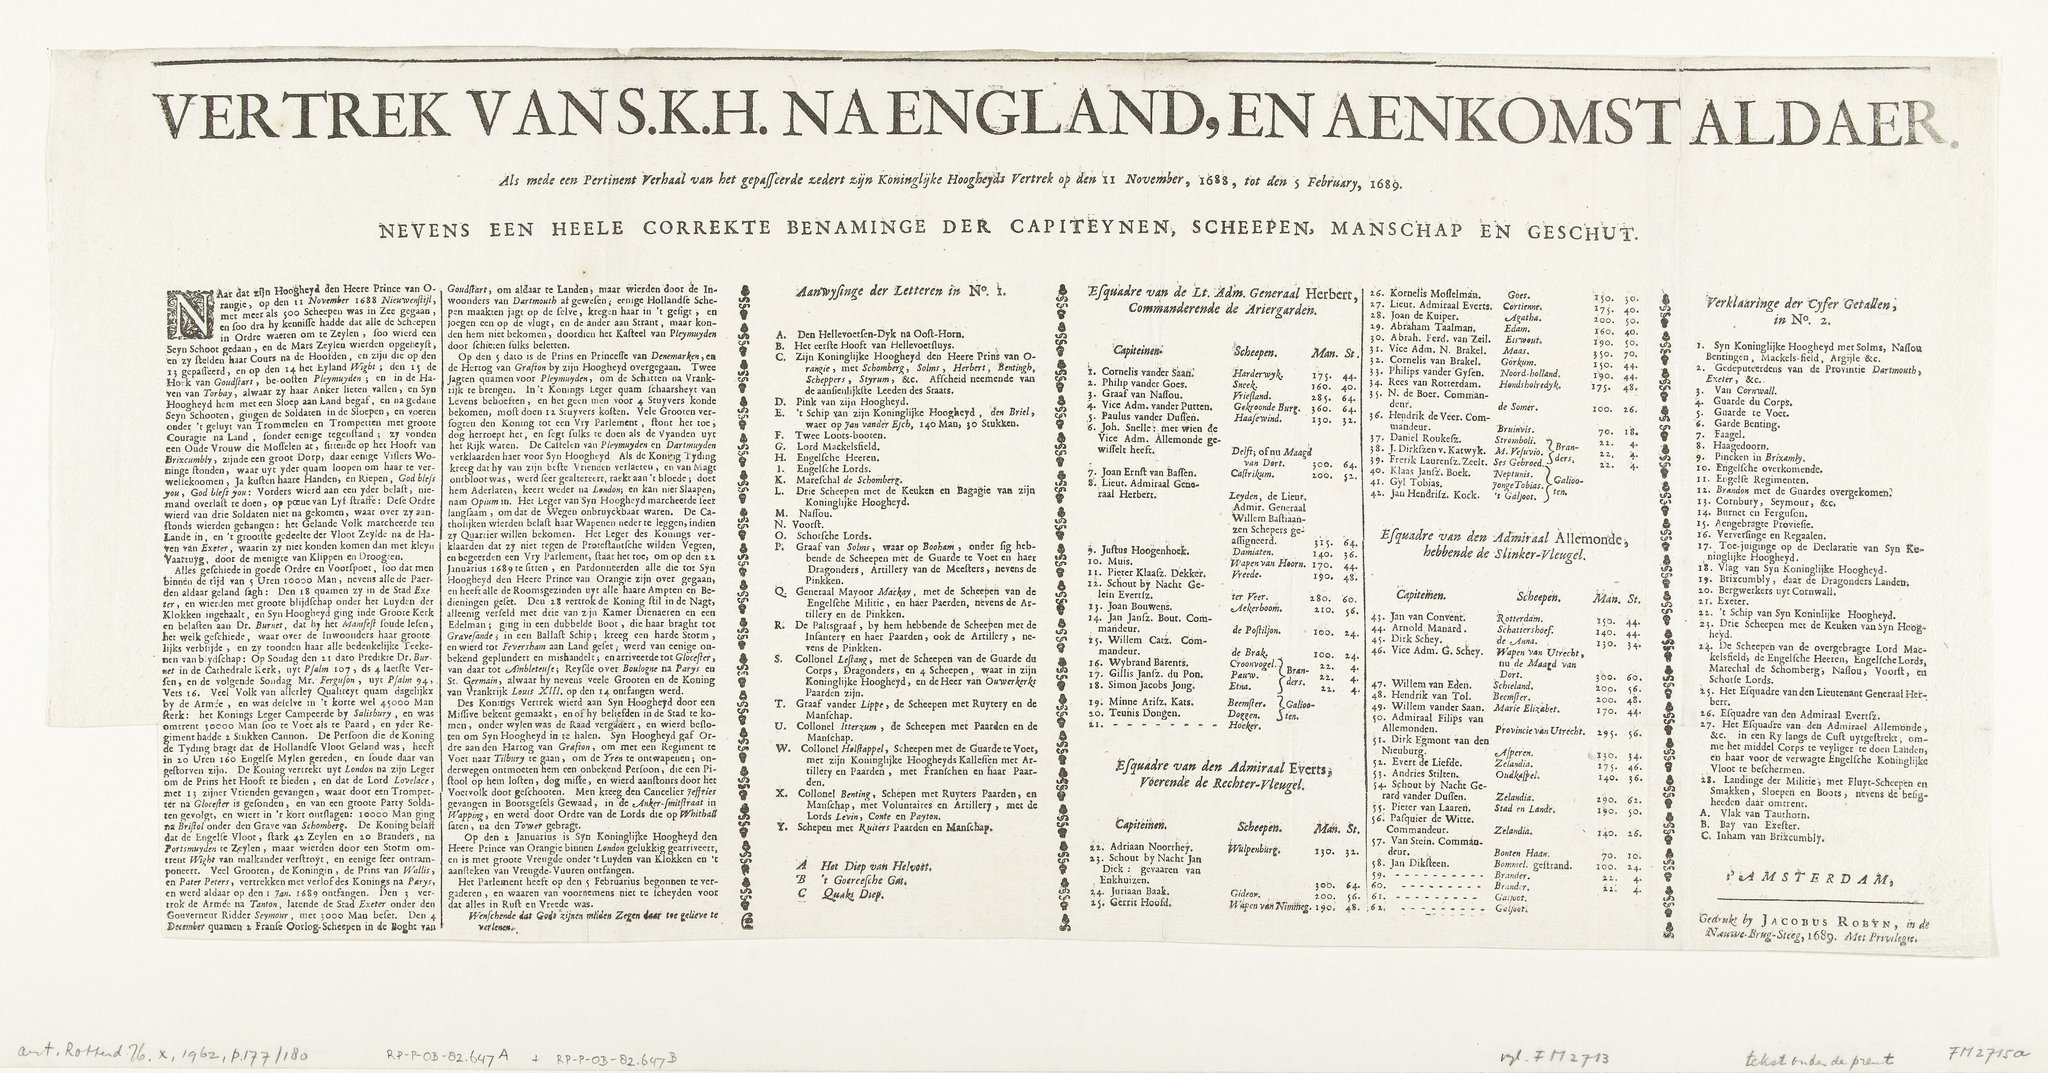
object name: text sheet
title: Tekstblad bij de prent van het vertrek van Willem III naar Engeland en aankomst aldaar, 1688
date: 1689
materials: paper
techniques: letterpress printing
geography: amsterdam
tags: the hague, william iii (prince of orange and king of england, scotland, and ireland), hellevoetsluis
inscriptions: date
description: Tekstblad bij de prent van de tocht van Willem III naar Engeland, 1688. Beschrijving van de tocht en gebeurtenissen vanaf 11 november 1688 tot aan 5 februari 1689, in twee kolommen met de legenda's A-Y en 1-28 en een lijst van schepen 1-62.